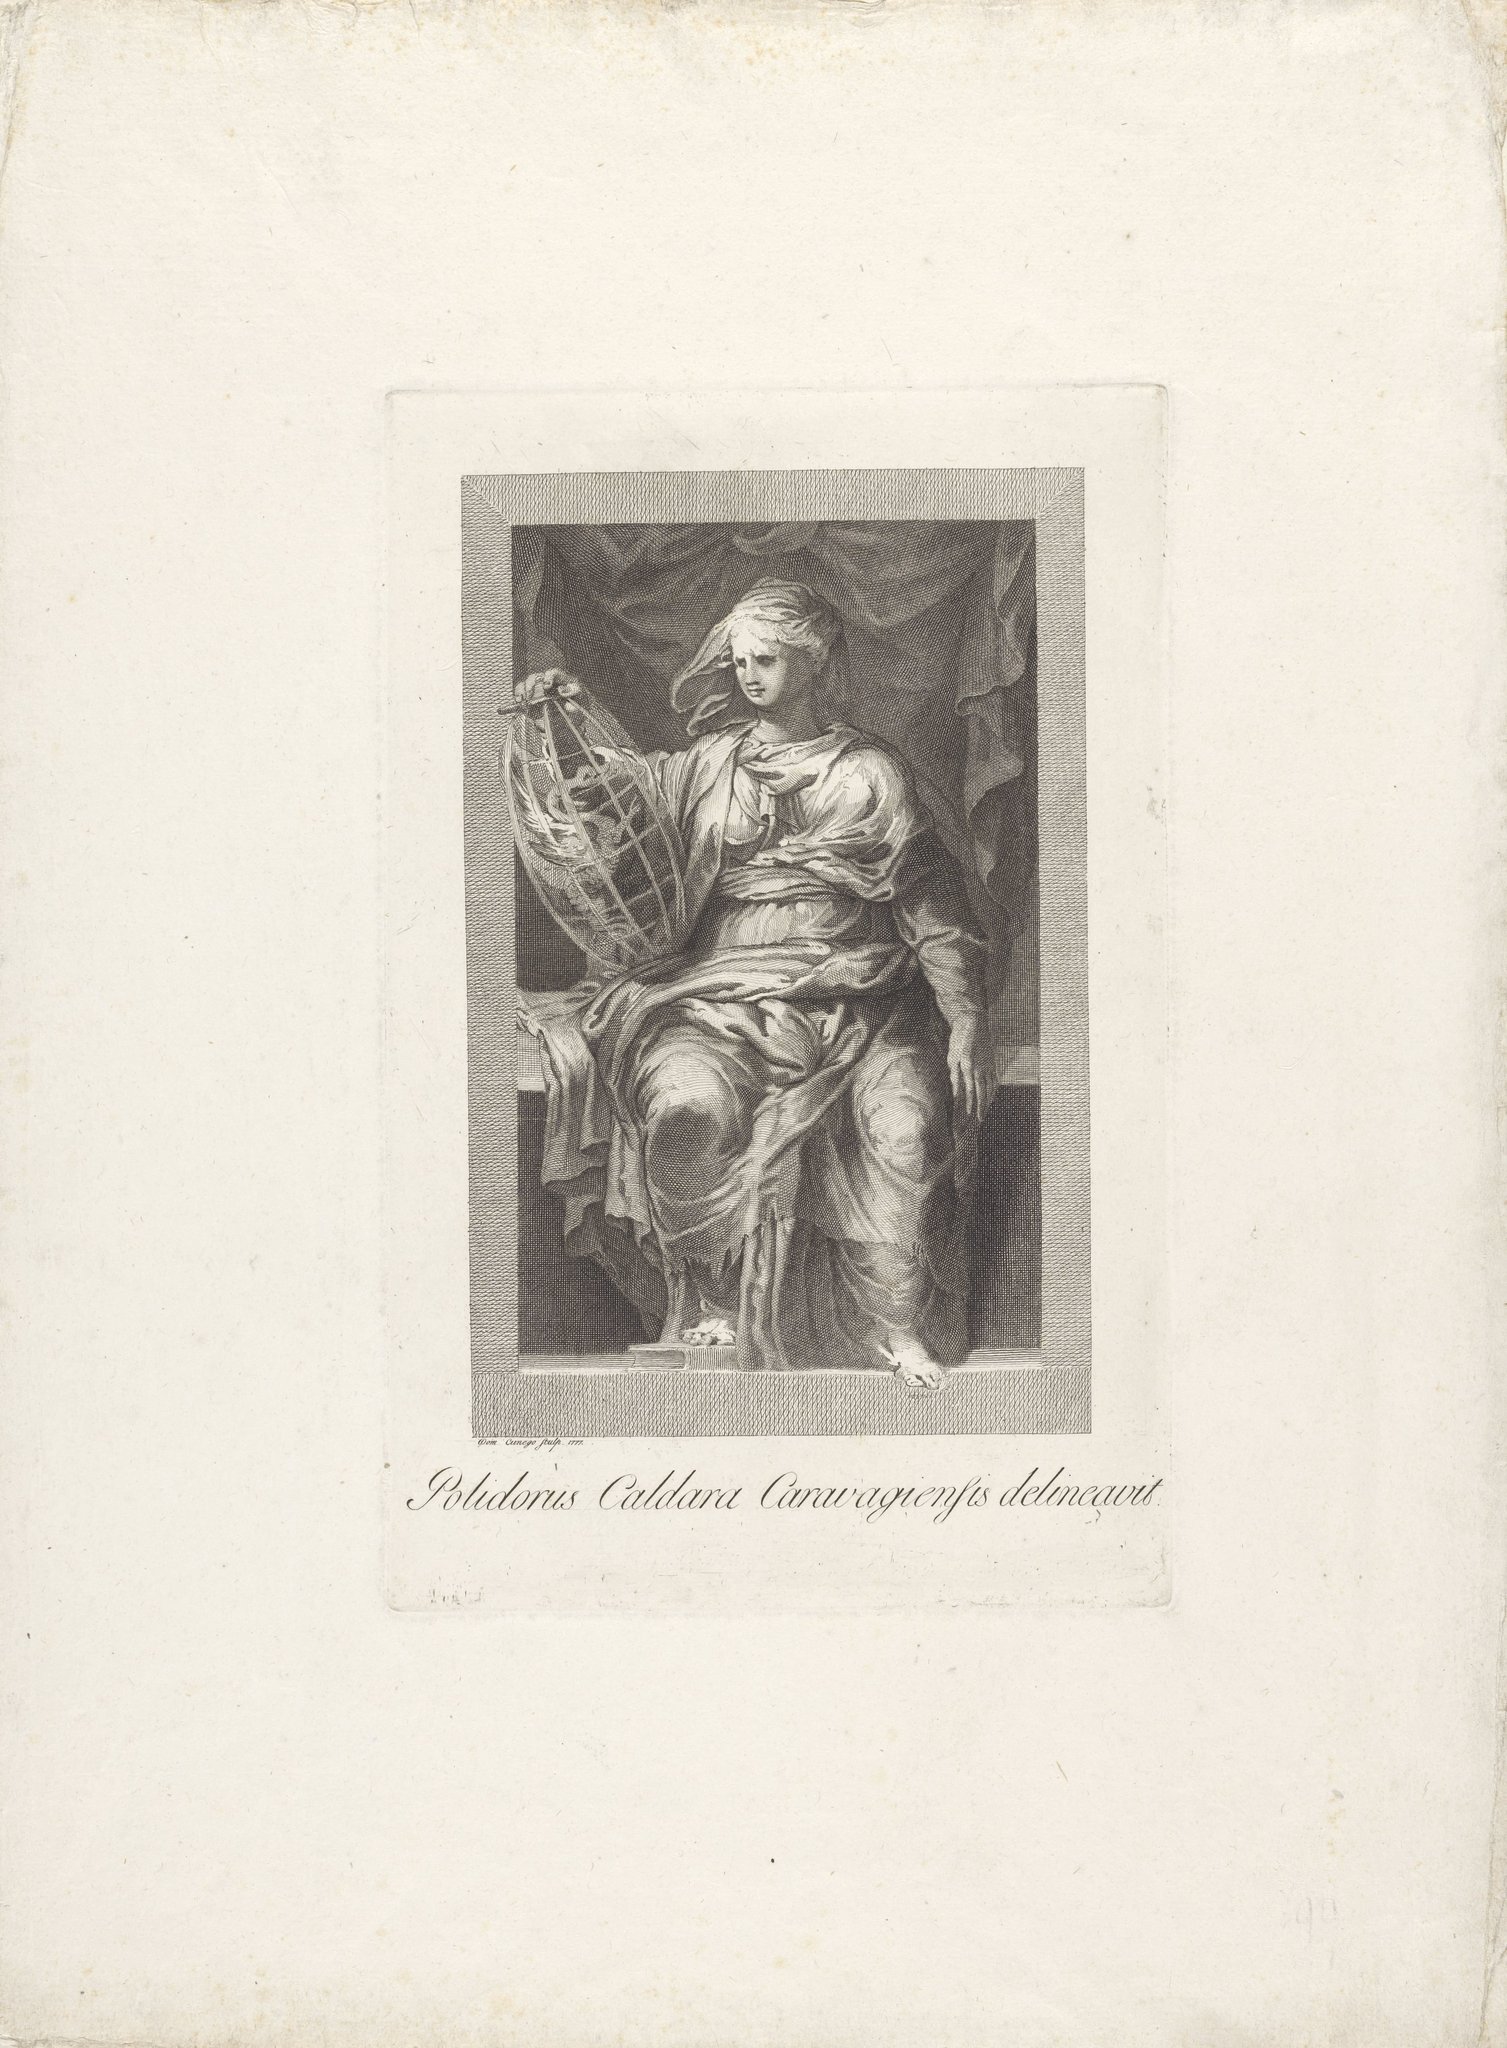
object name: print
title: Vrouw met draak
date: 1777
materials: paper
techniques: engraving, etching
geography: italy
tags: the patroness of housewives, martha of bethany; possible attributes: aspergillum, broom, bunch of keys, dragon, ladle, the virgin martyr margaret of antioch; possible attributes: cross, crown, dragon (under feet or on chain), (chaplet of) pearls, dragon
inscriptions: collector's mark: Lugt 2228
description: Mogelijk de heilige Marta of Margareta van Antiochië, zittend voor een draperie, met in haar hand een kooi met een kleine draak.